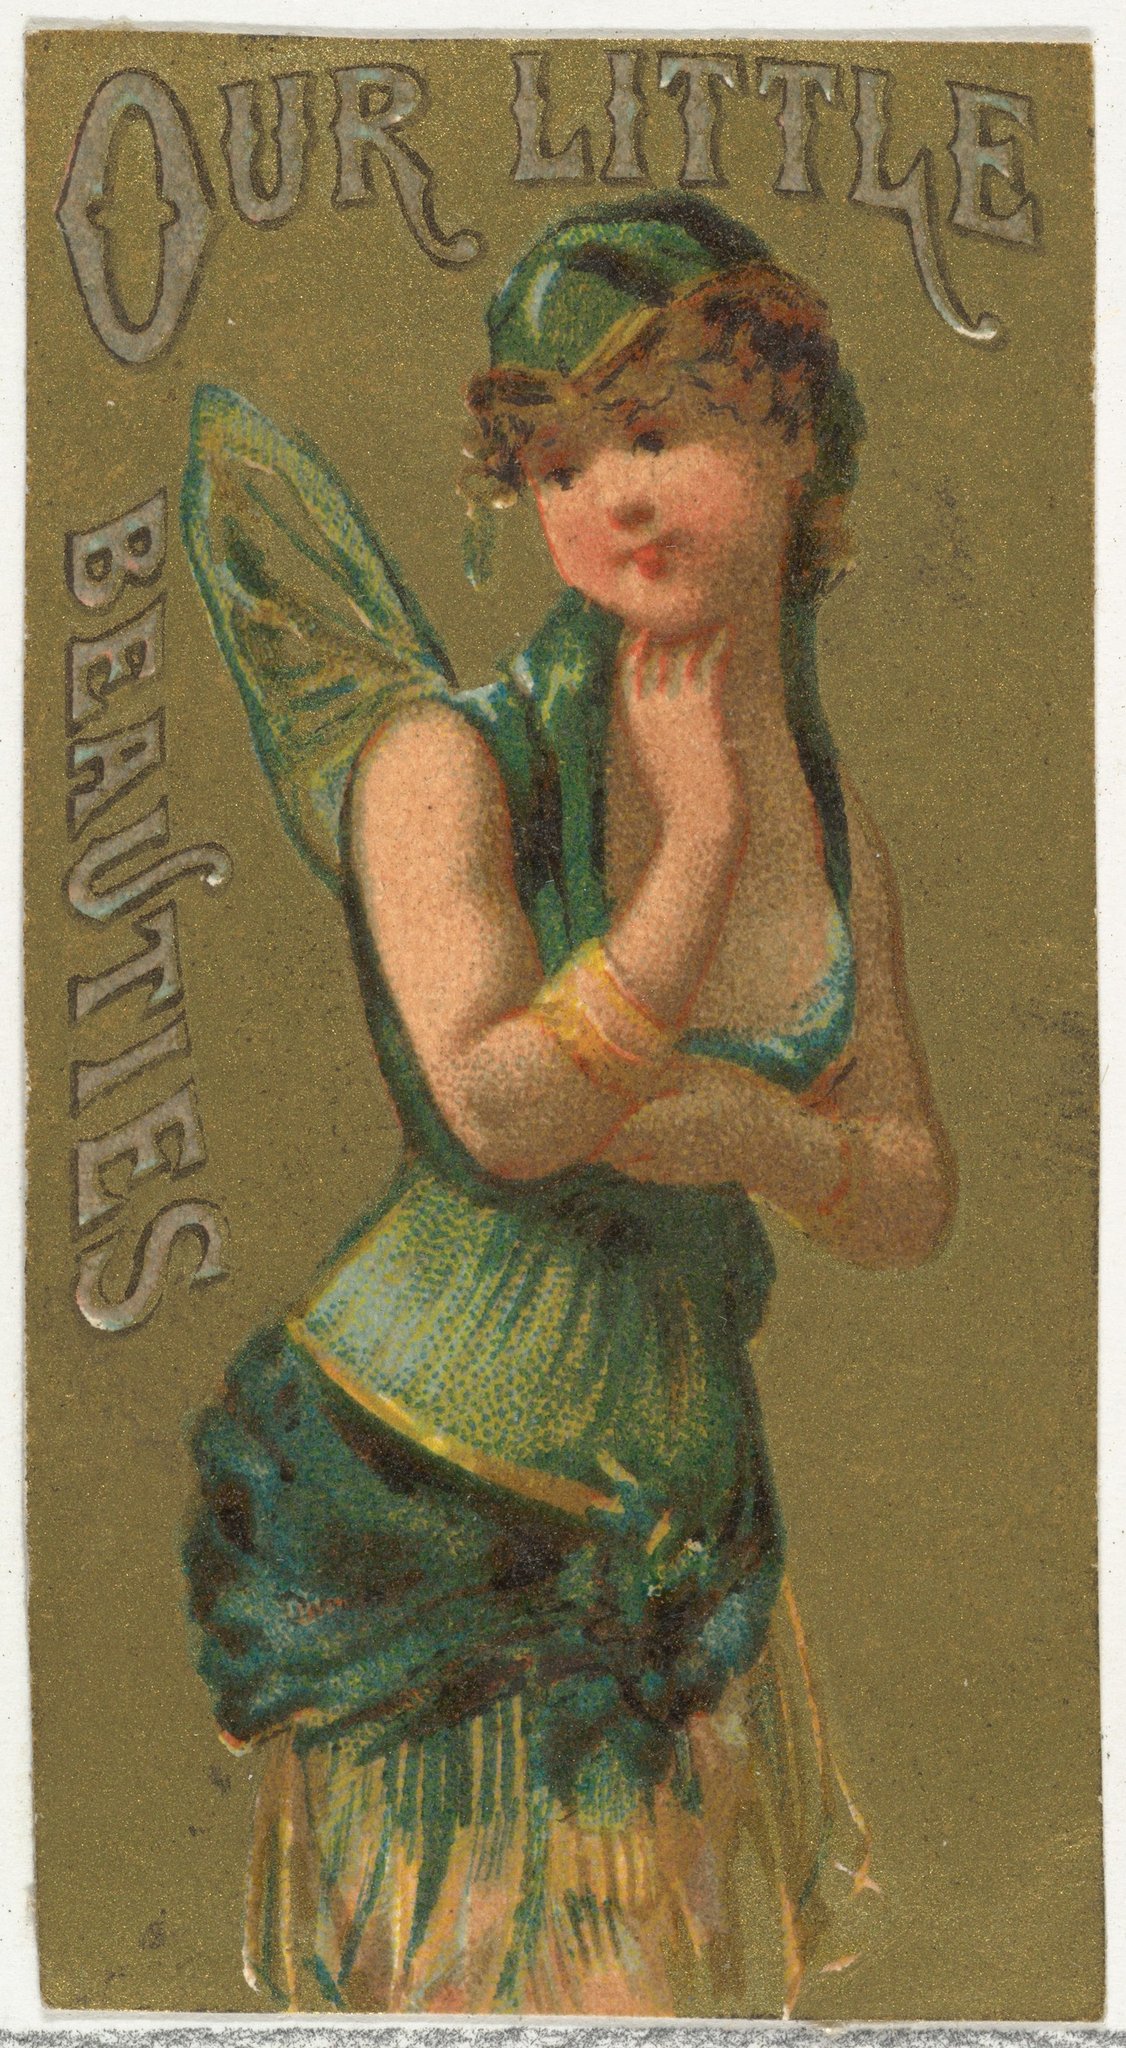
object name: print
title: From the Girls and Children series (N58) promoting Our Little Beauties Cigarettes for Allen & Ginter brand tobacco products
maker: allen & ginter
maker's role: publisher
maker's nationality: american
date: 1887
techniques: color lithograph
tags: girls